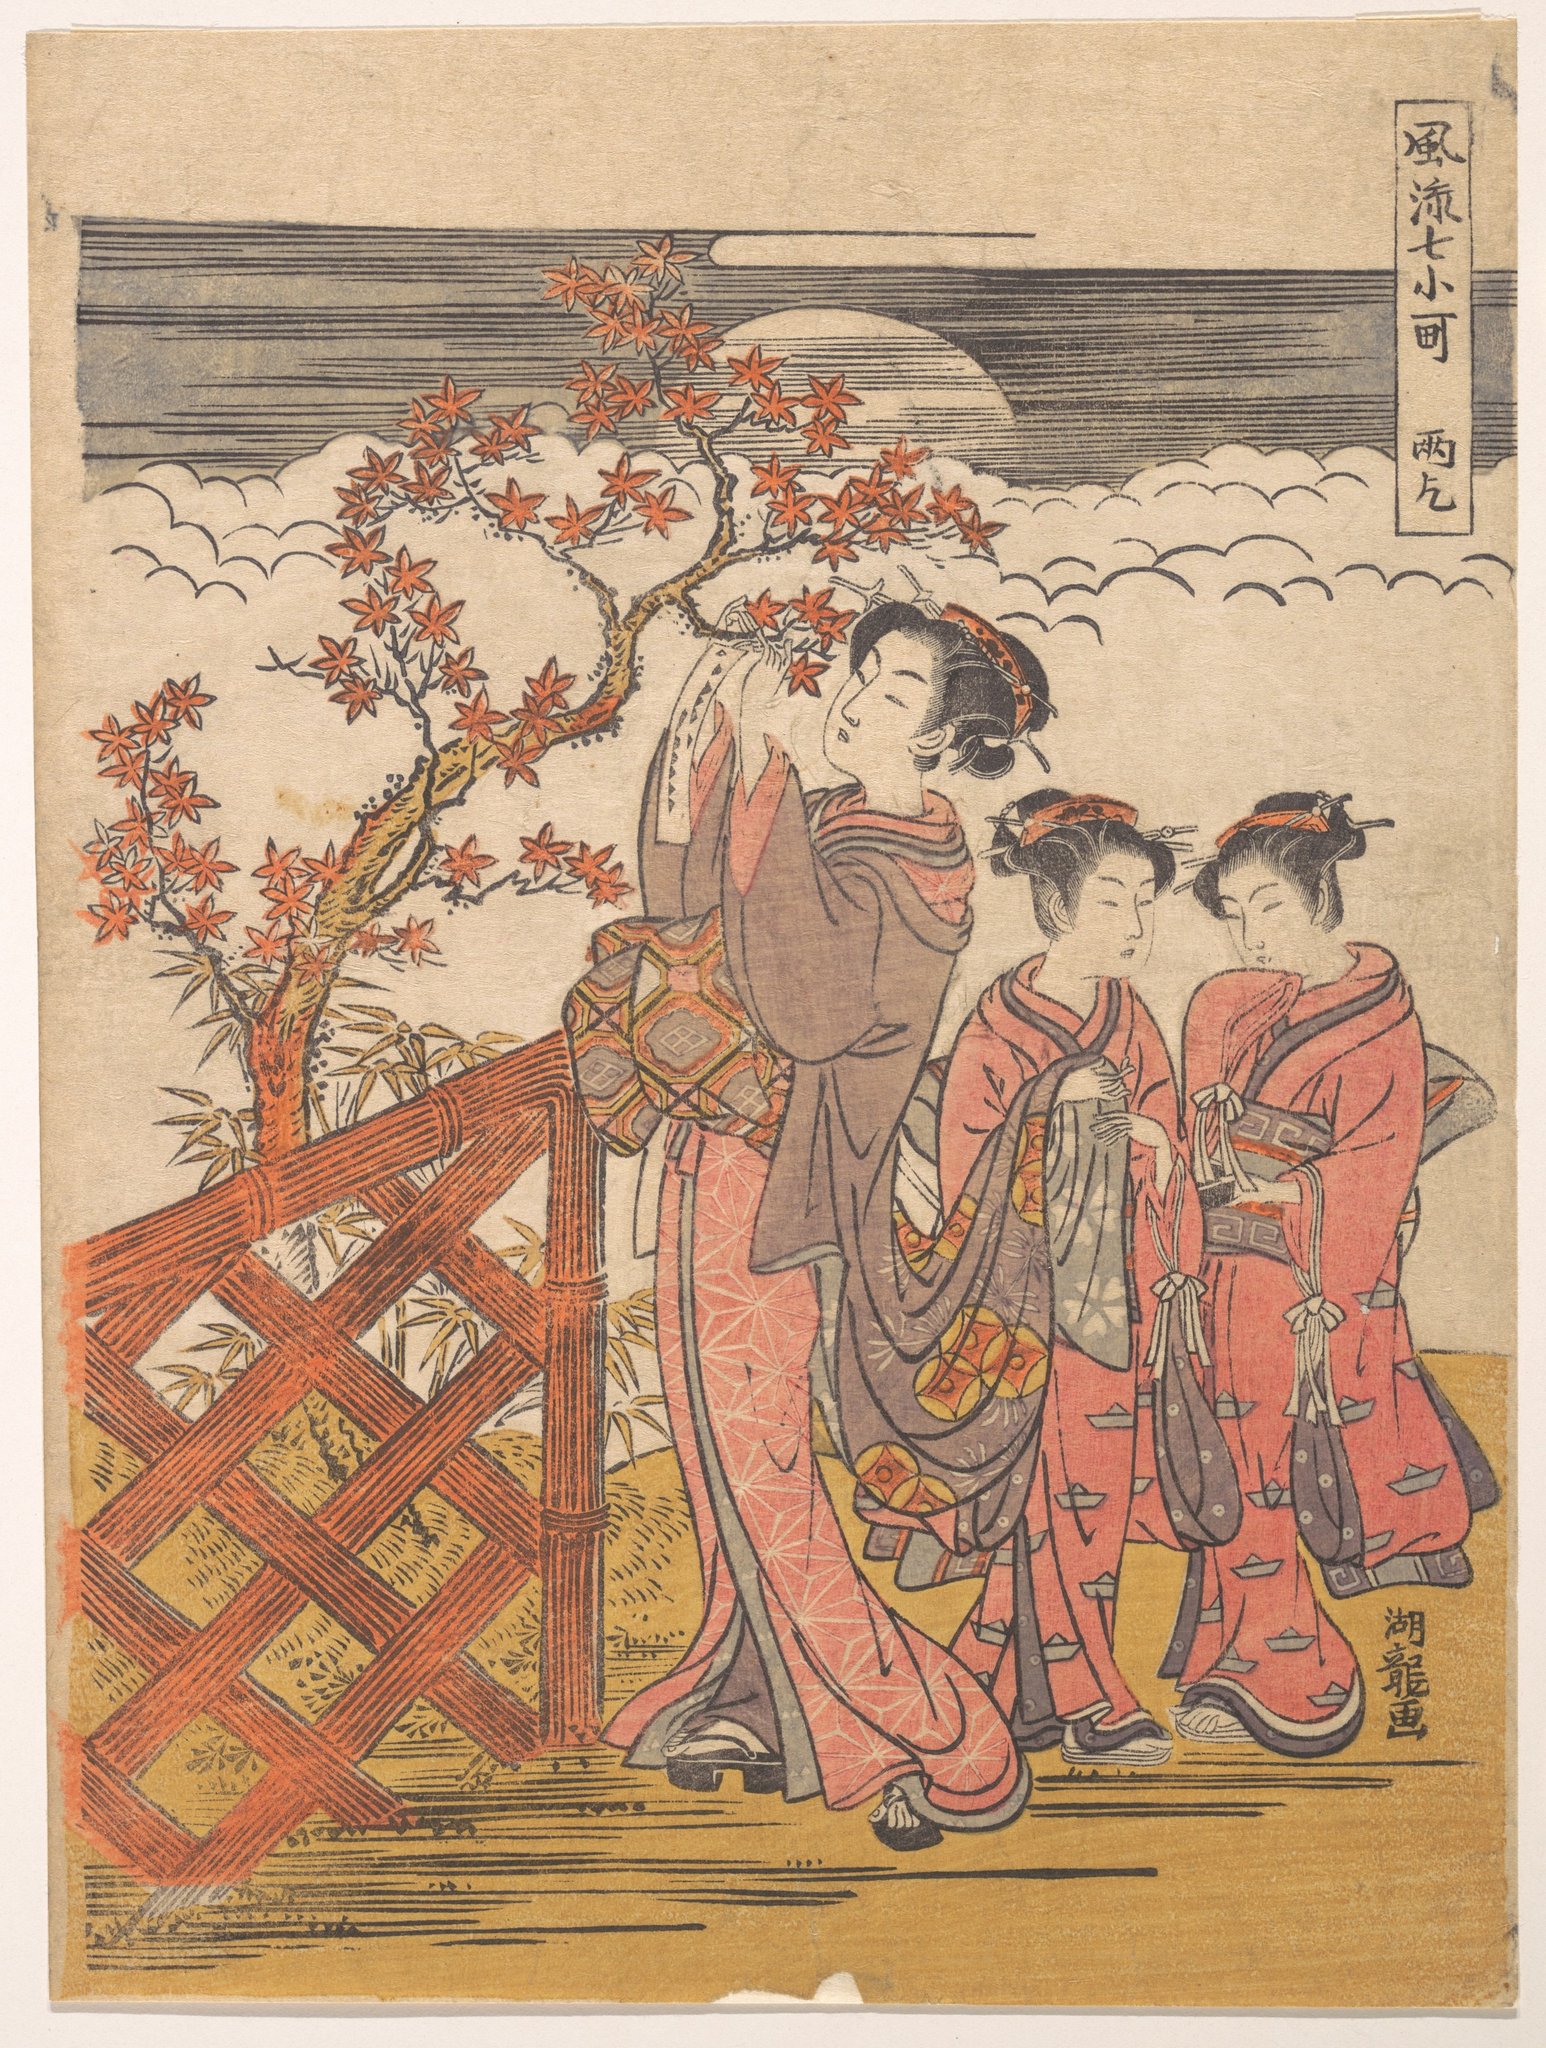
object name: print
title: One of the Seven Komachi: Amagoi (Praying for Rain)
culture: japanese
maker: isoda koryūsai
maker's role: artist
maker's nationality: japanese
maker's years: 1735-1790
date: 1770-1790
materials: ink, paper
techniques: woodblock print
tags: women